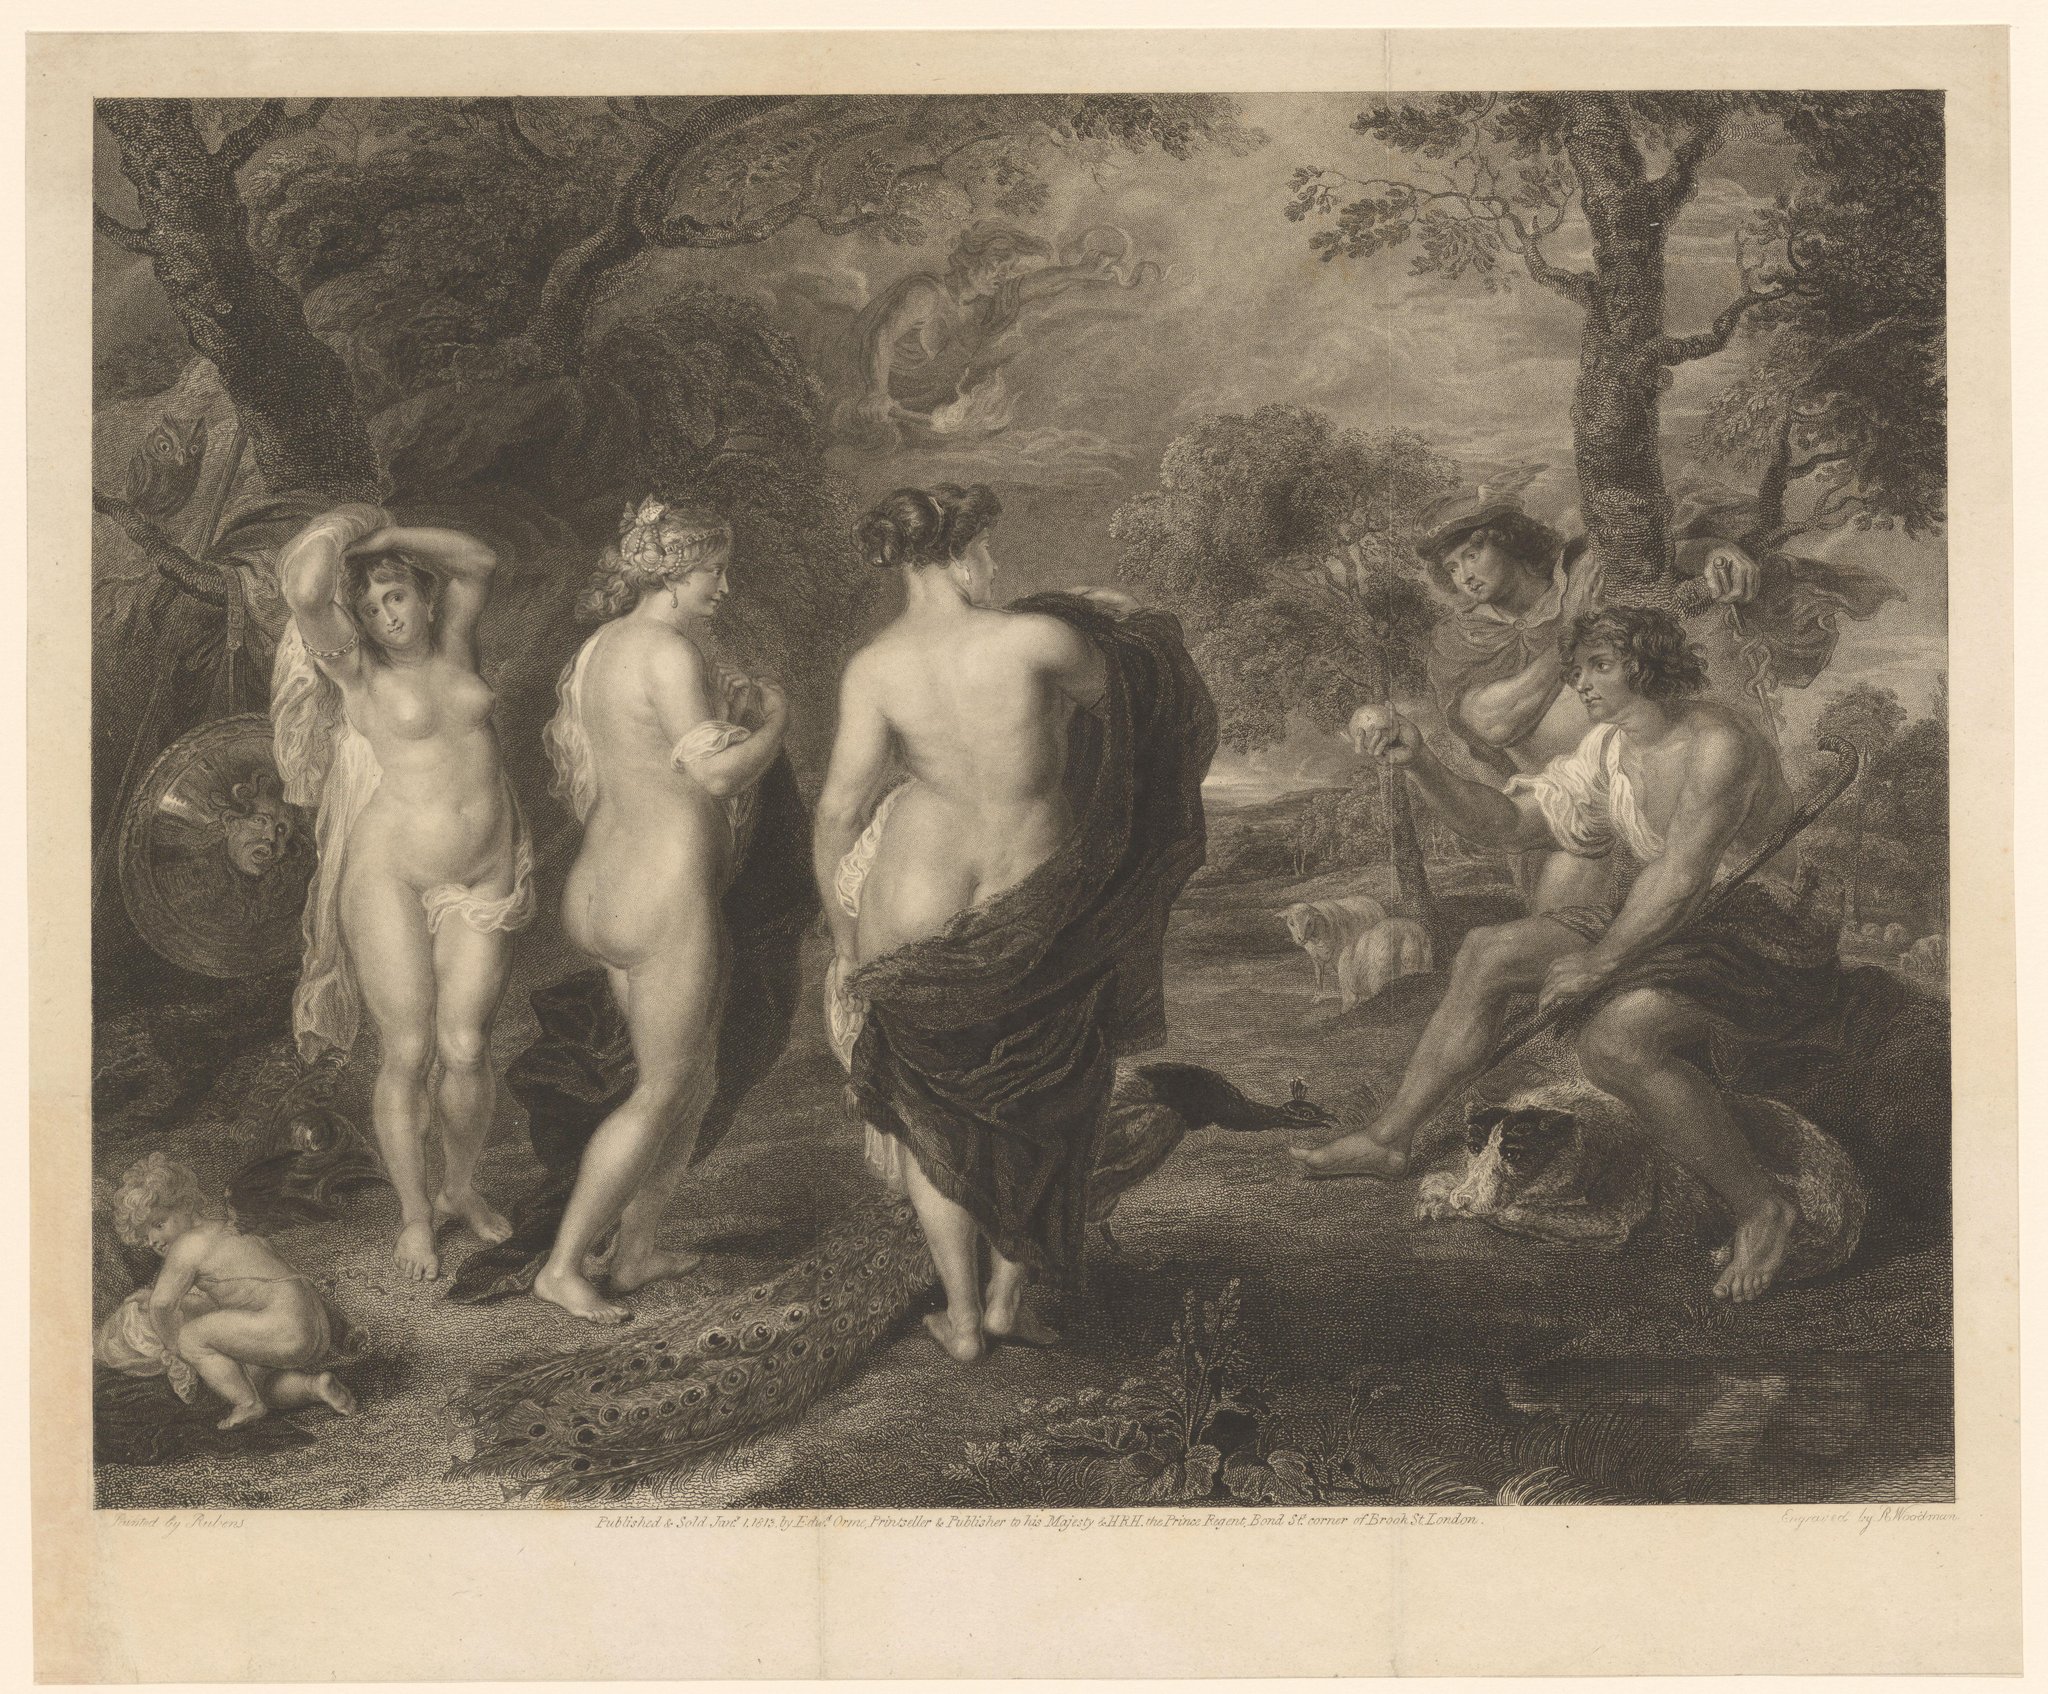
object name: print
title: Oordeel van Paris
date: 1806-1813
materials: paper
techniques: etching, engraving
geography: london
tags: the judgement of paris (mercury present), invidia (envy) as roman personification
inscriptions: date